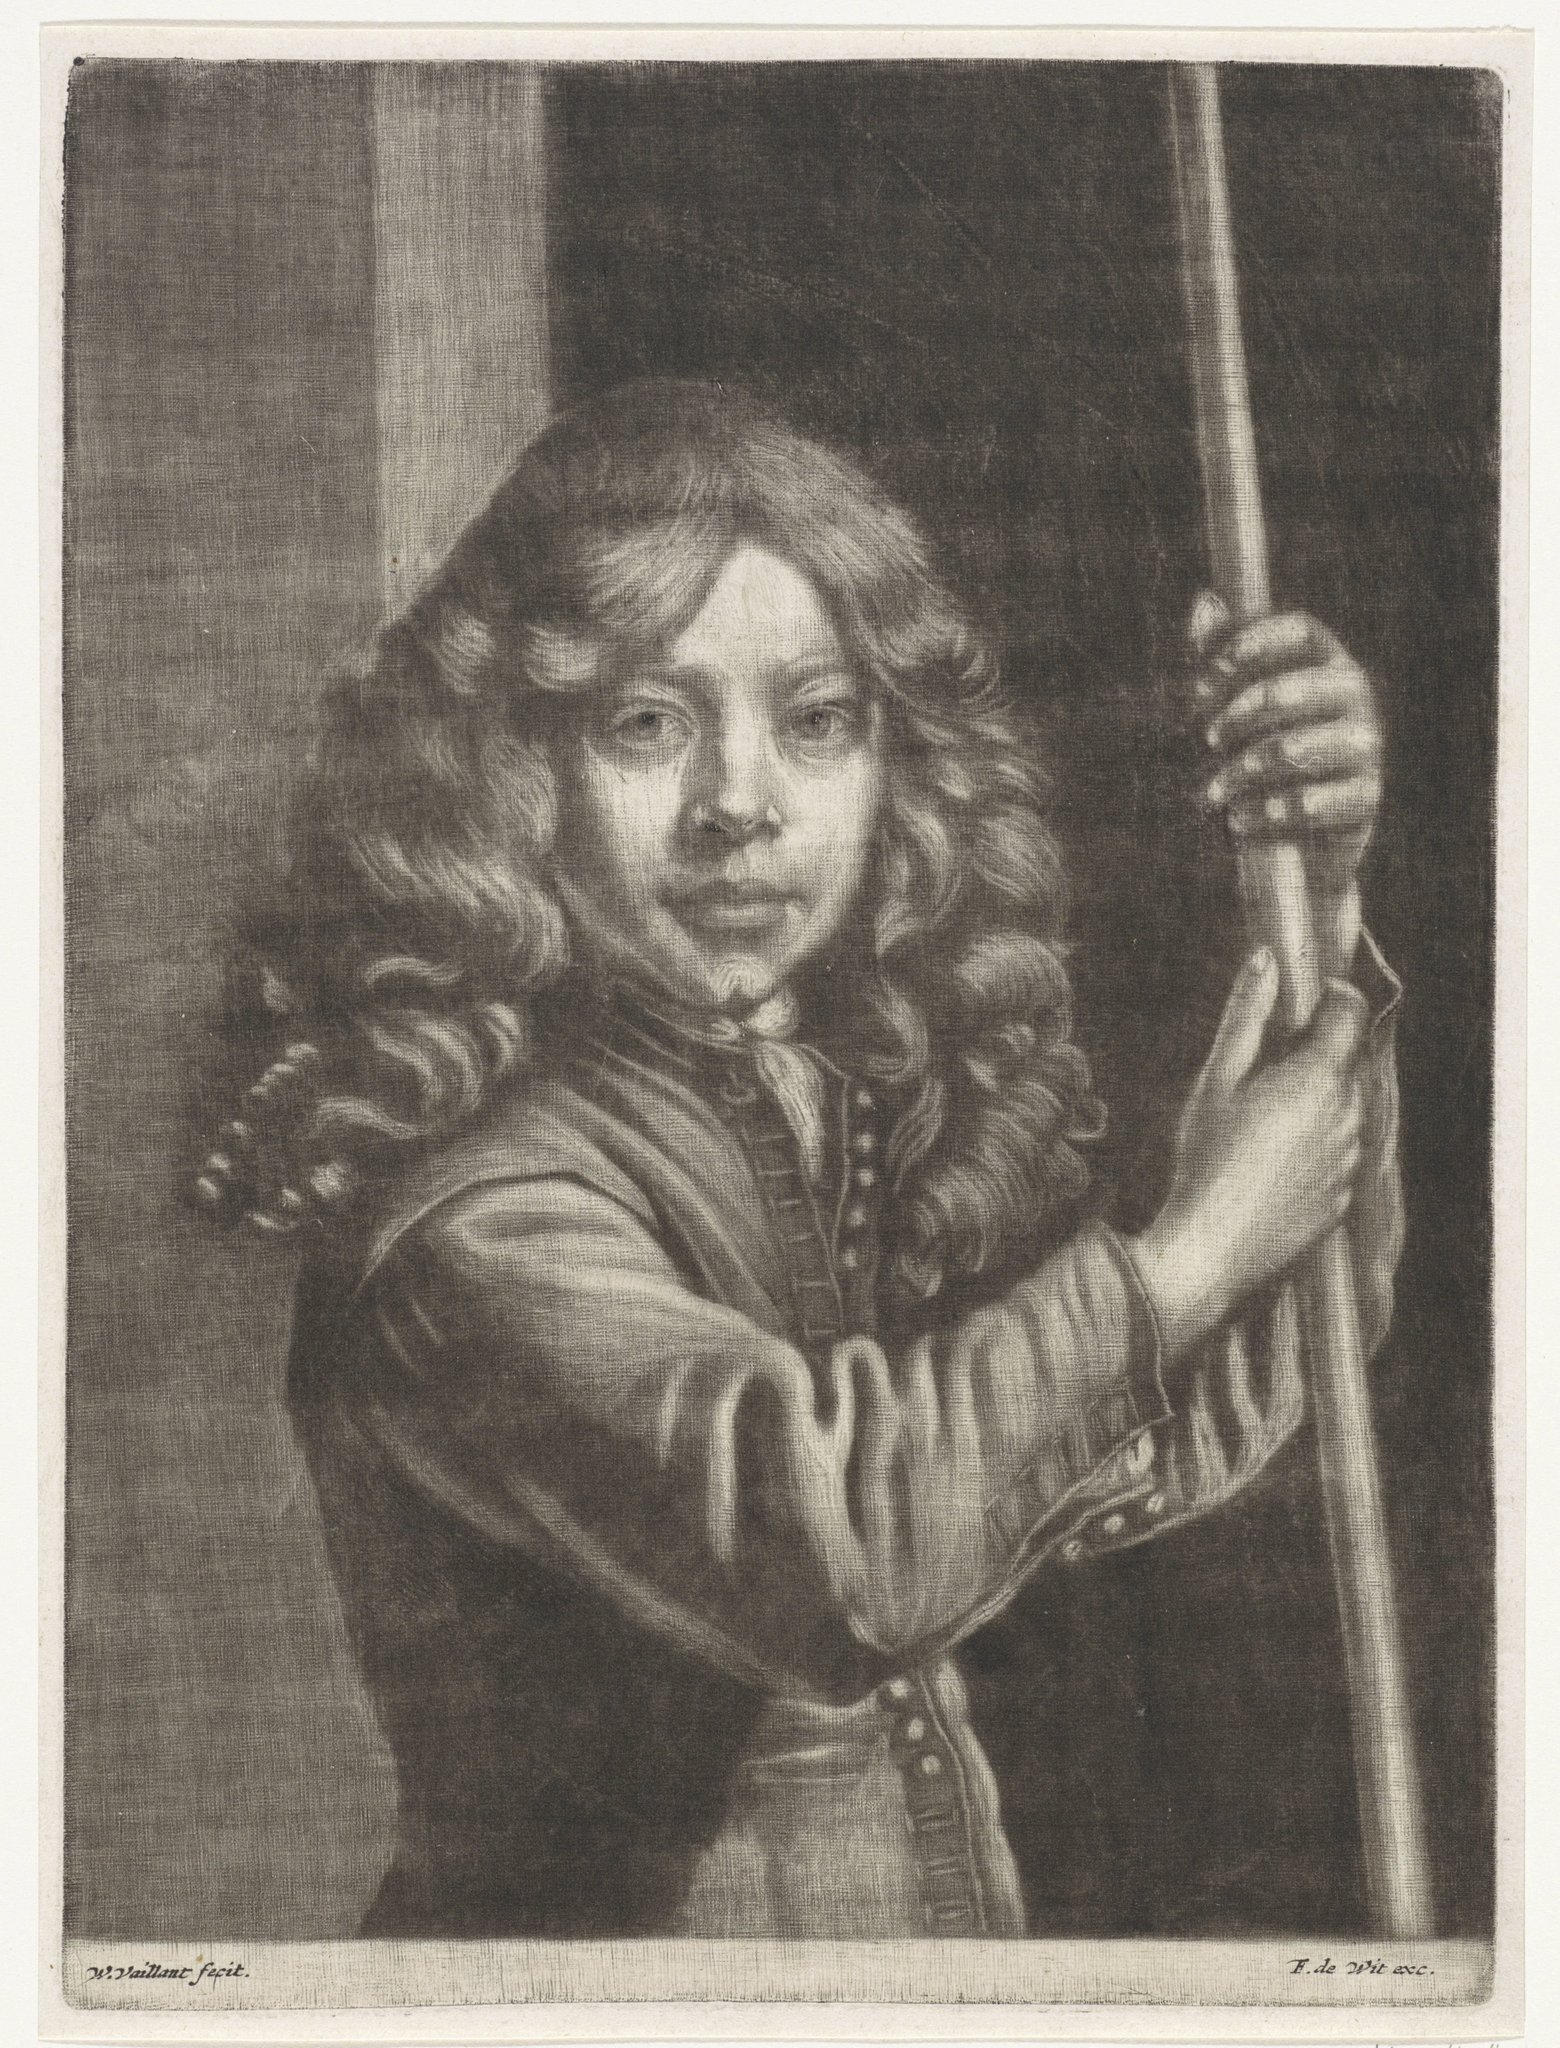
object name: print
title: Jonge vaandeldrager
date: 1658-1706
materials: paper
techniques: mezzotint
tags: standard-bearer, flag-bearer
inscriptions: collector's mark: Lugt 2228